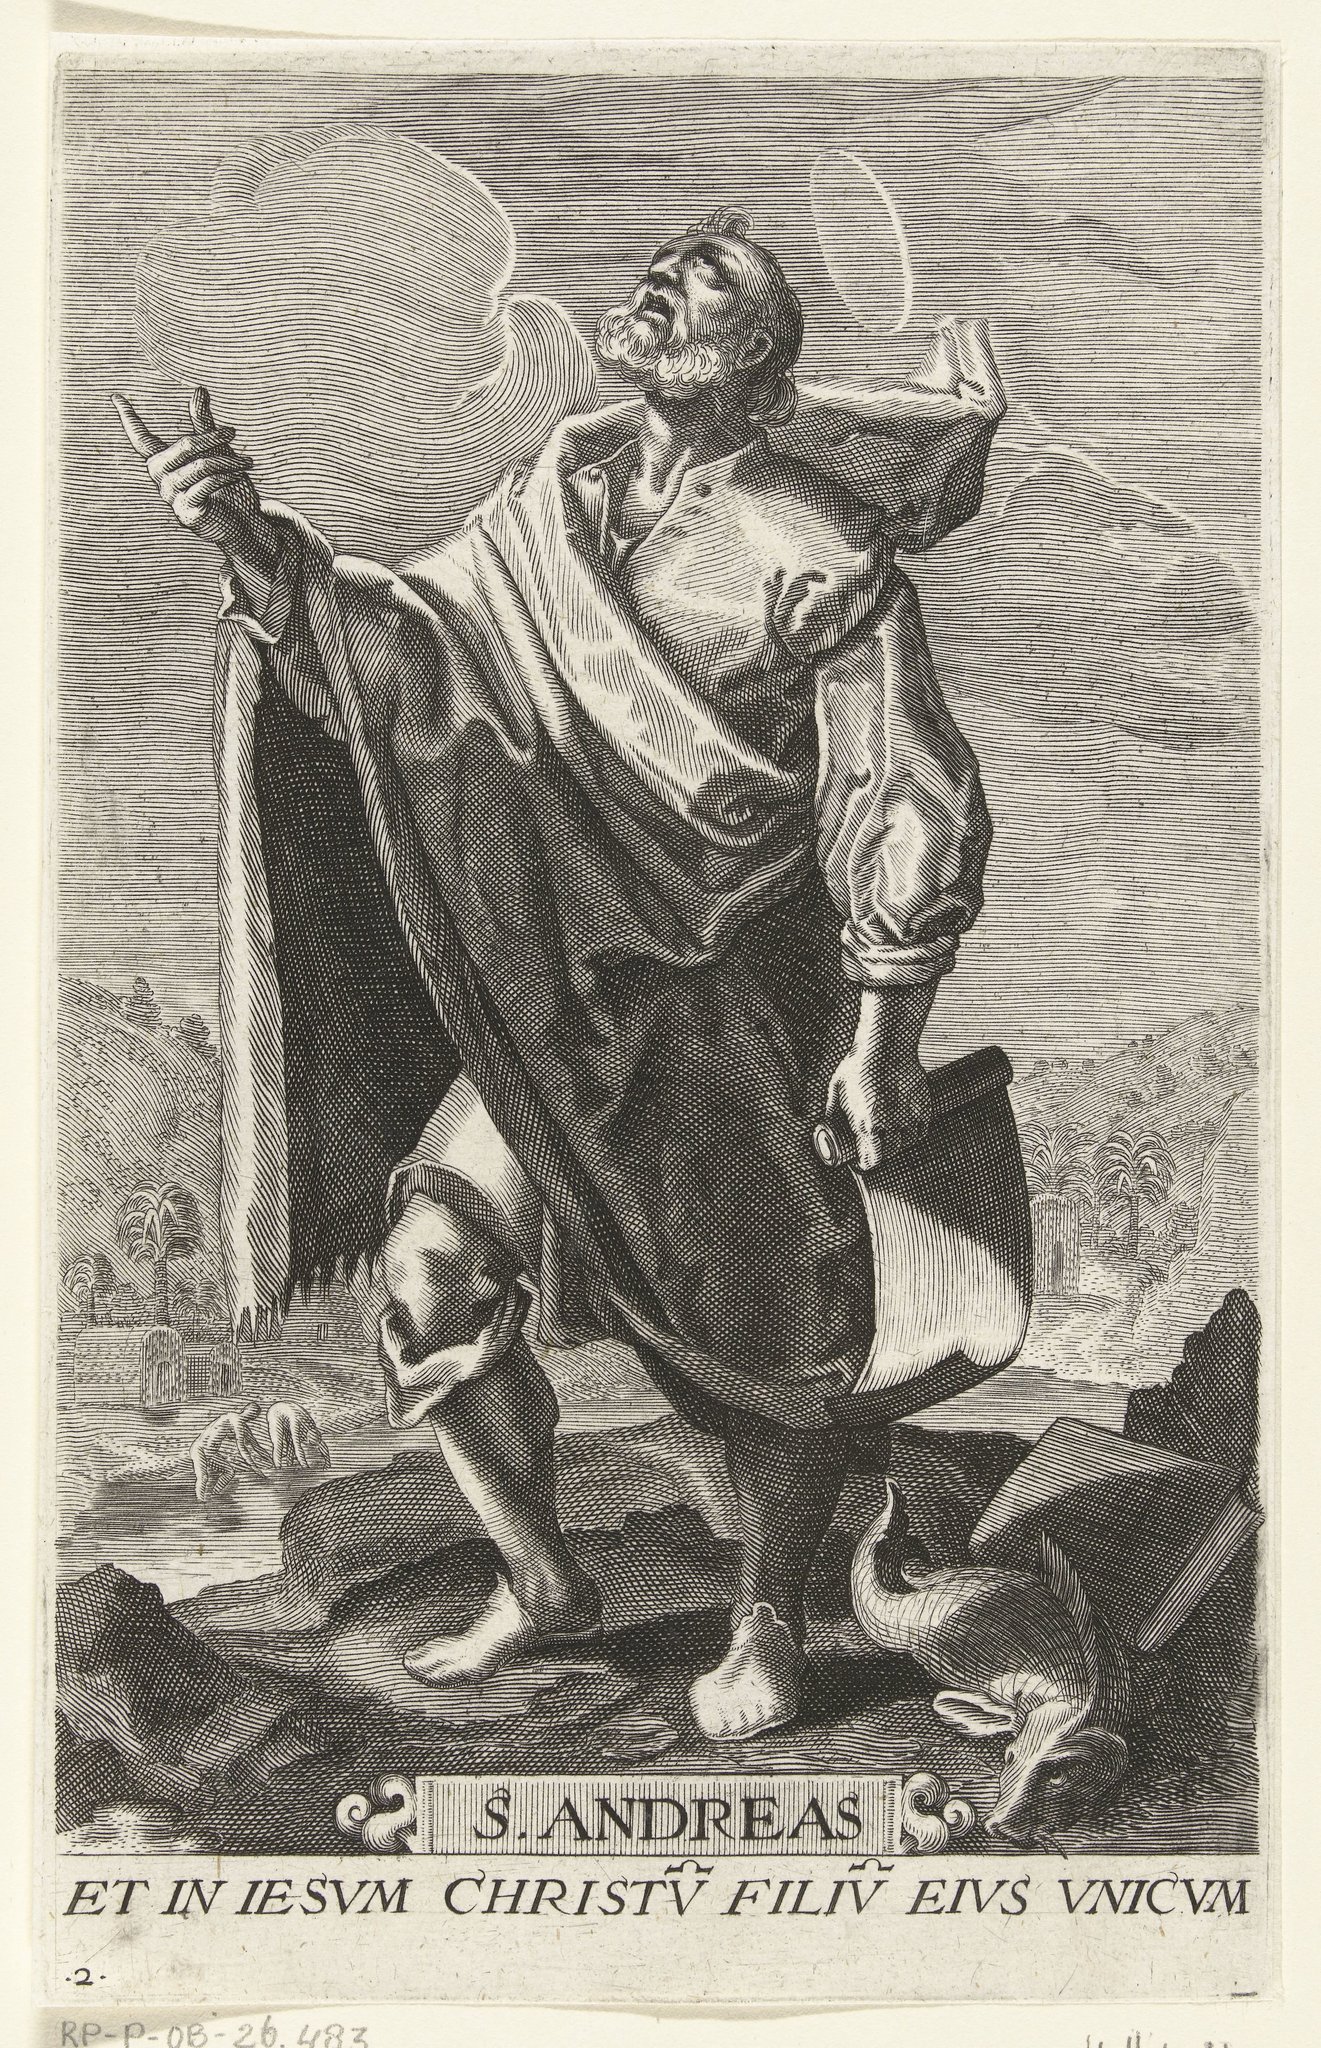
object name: print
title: Christus en twaalf apostelen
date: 1591-1629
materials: paper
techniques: engraving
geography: prague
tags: the apostle andrew; possible attributes: book, x-shaped cross, fish, fishing-net, rope, scroll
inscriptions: collector's mark: Lugt 2228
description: Prent naar ontwerp van Joos van Winghe. Prent maakt deel uit van serie met dertien prenten en titelprent van Christus en twaalf apostelen.